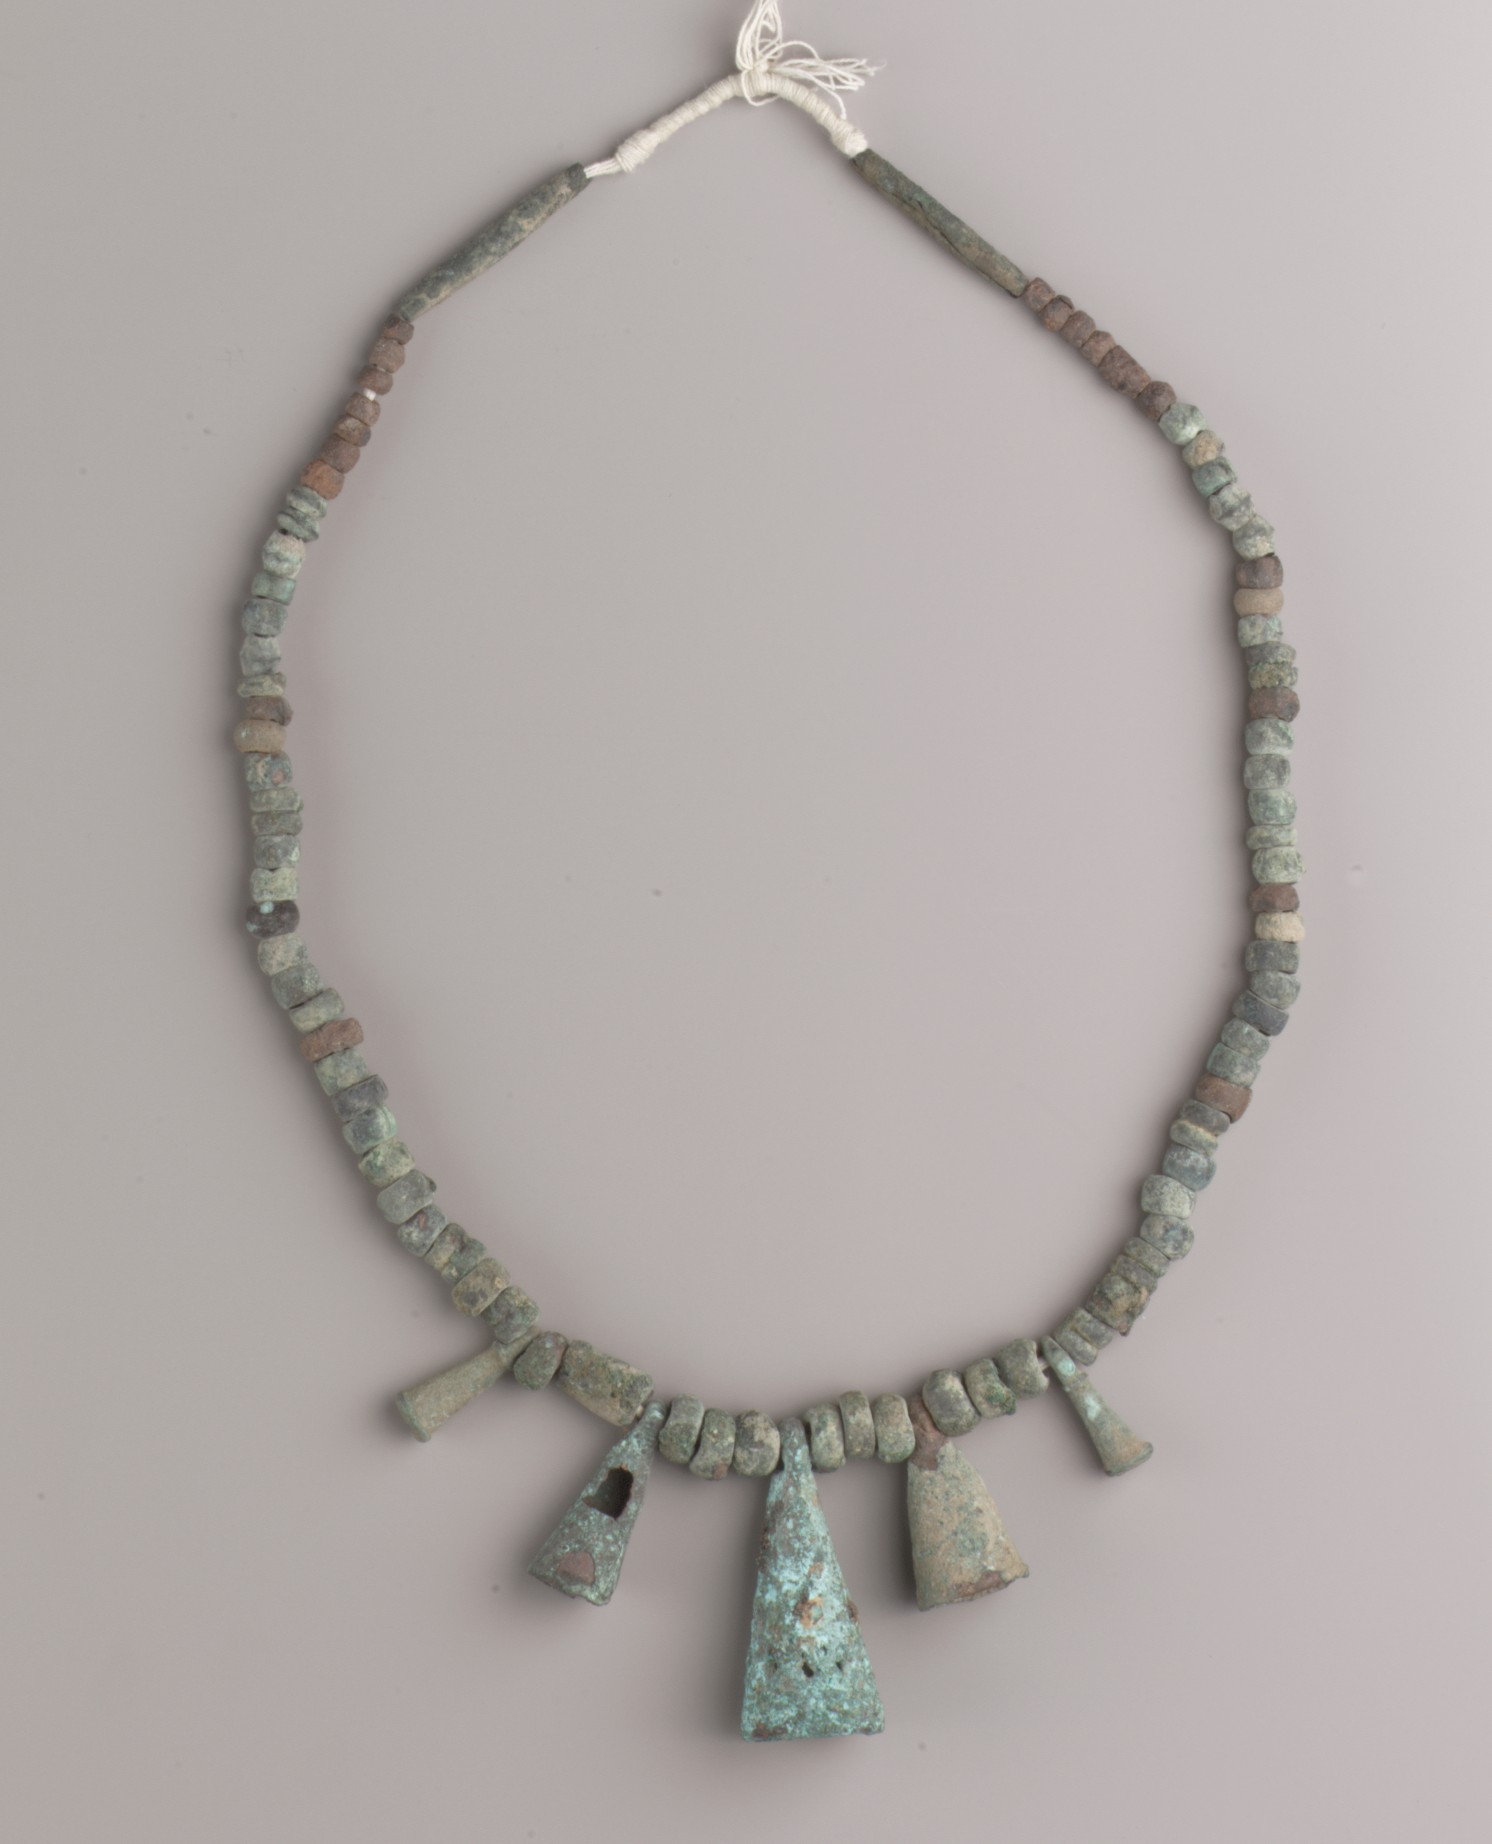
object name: necklace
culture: middle niger civilization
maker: middle niger artist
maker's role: artist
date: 1301-1400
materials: copper alloy, cord, cotton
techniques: casting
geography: mali